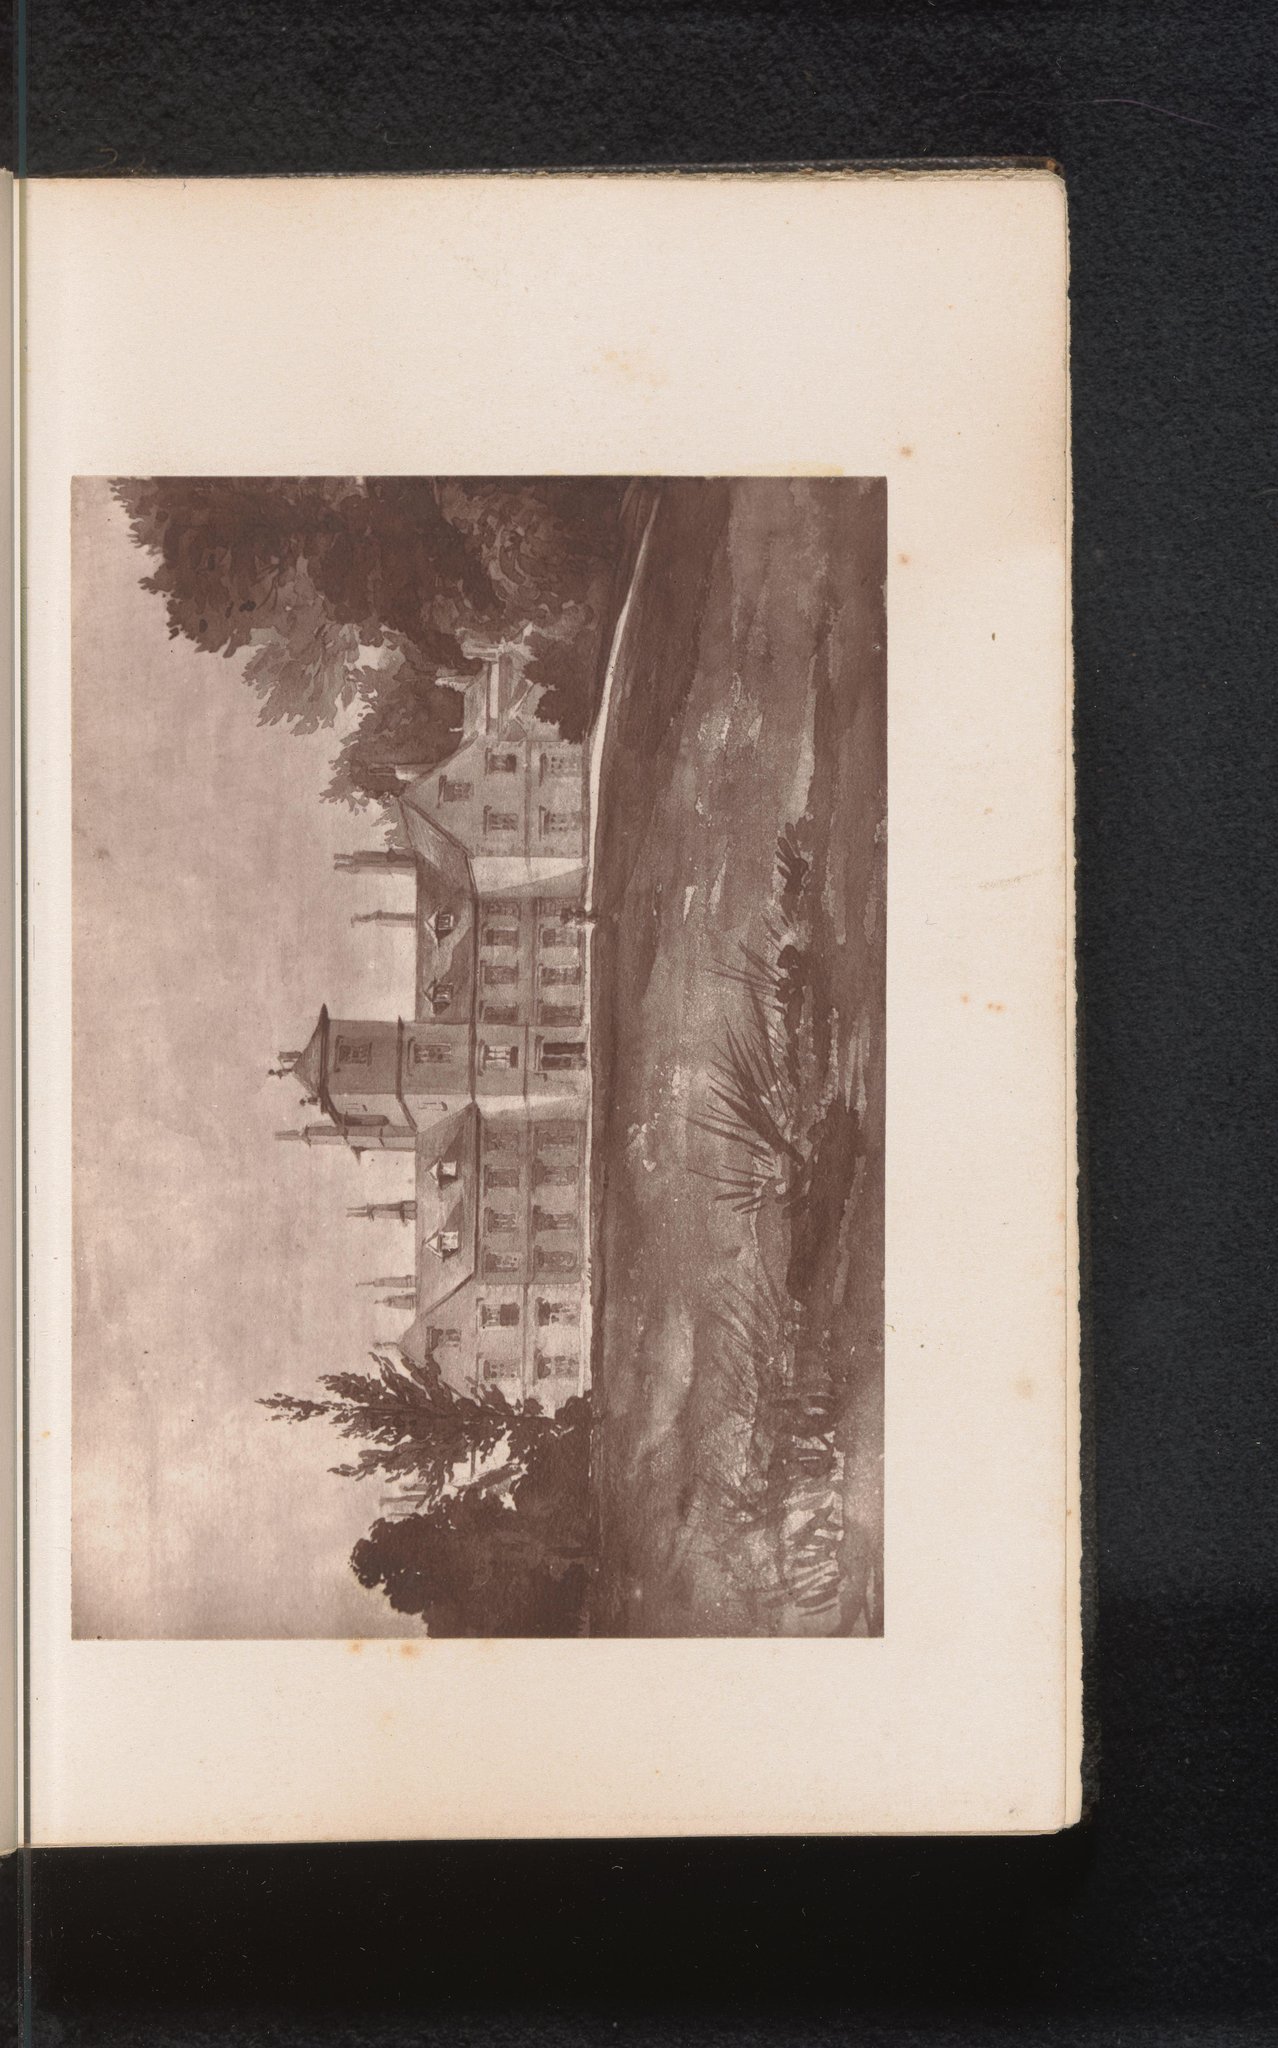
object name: page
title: Fotoreproductie van een schildering, voorstellende een gezicht op Toft Hall te Cheshire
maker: Anonymous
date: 1866-1876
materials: paper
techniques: woodburytype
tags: rural housing, e.g. country-house, villa, cottage, façade (of house or building)